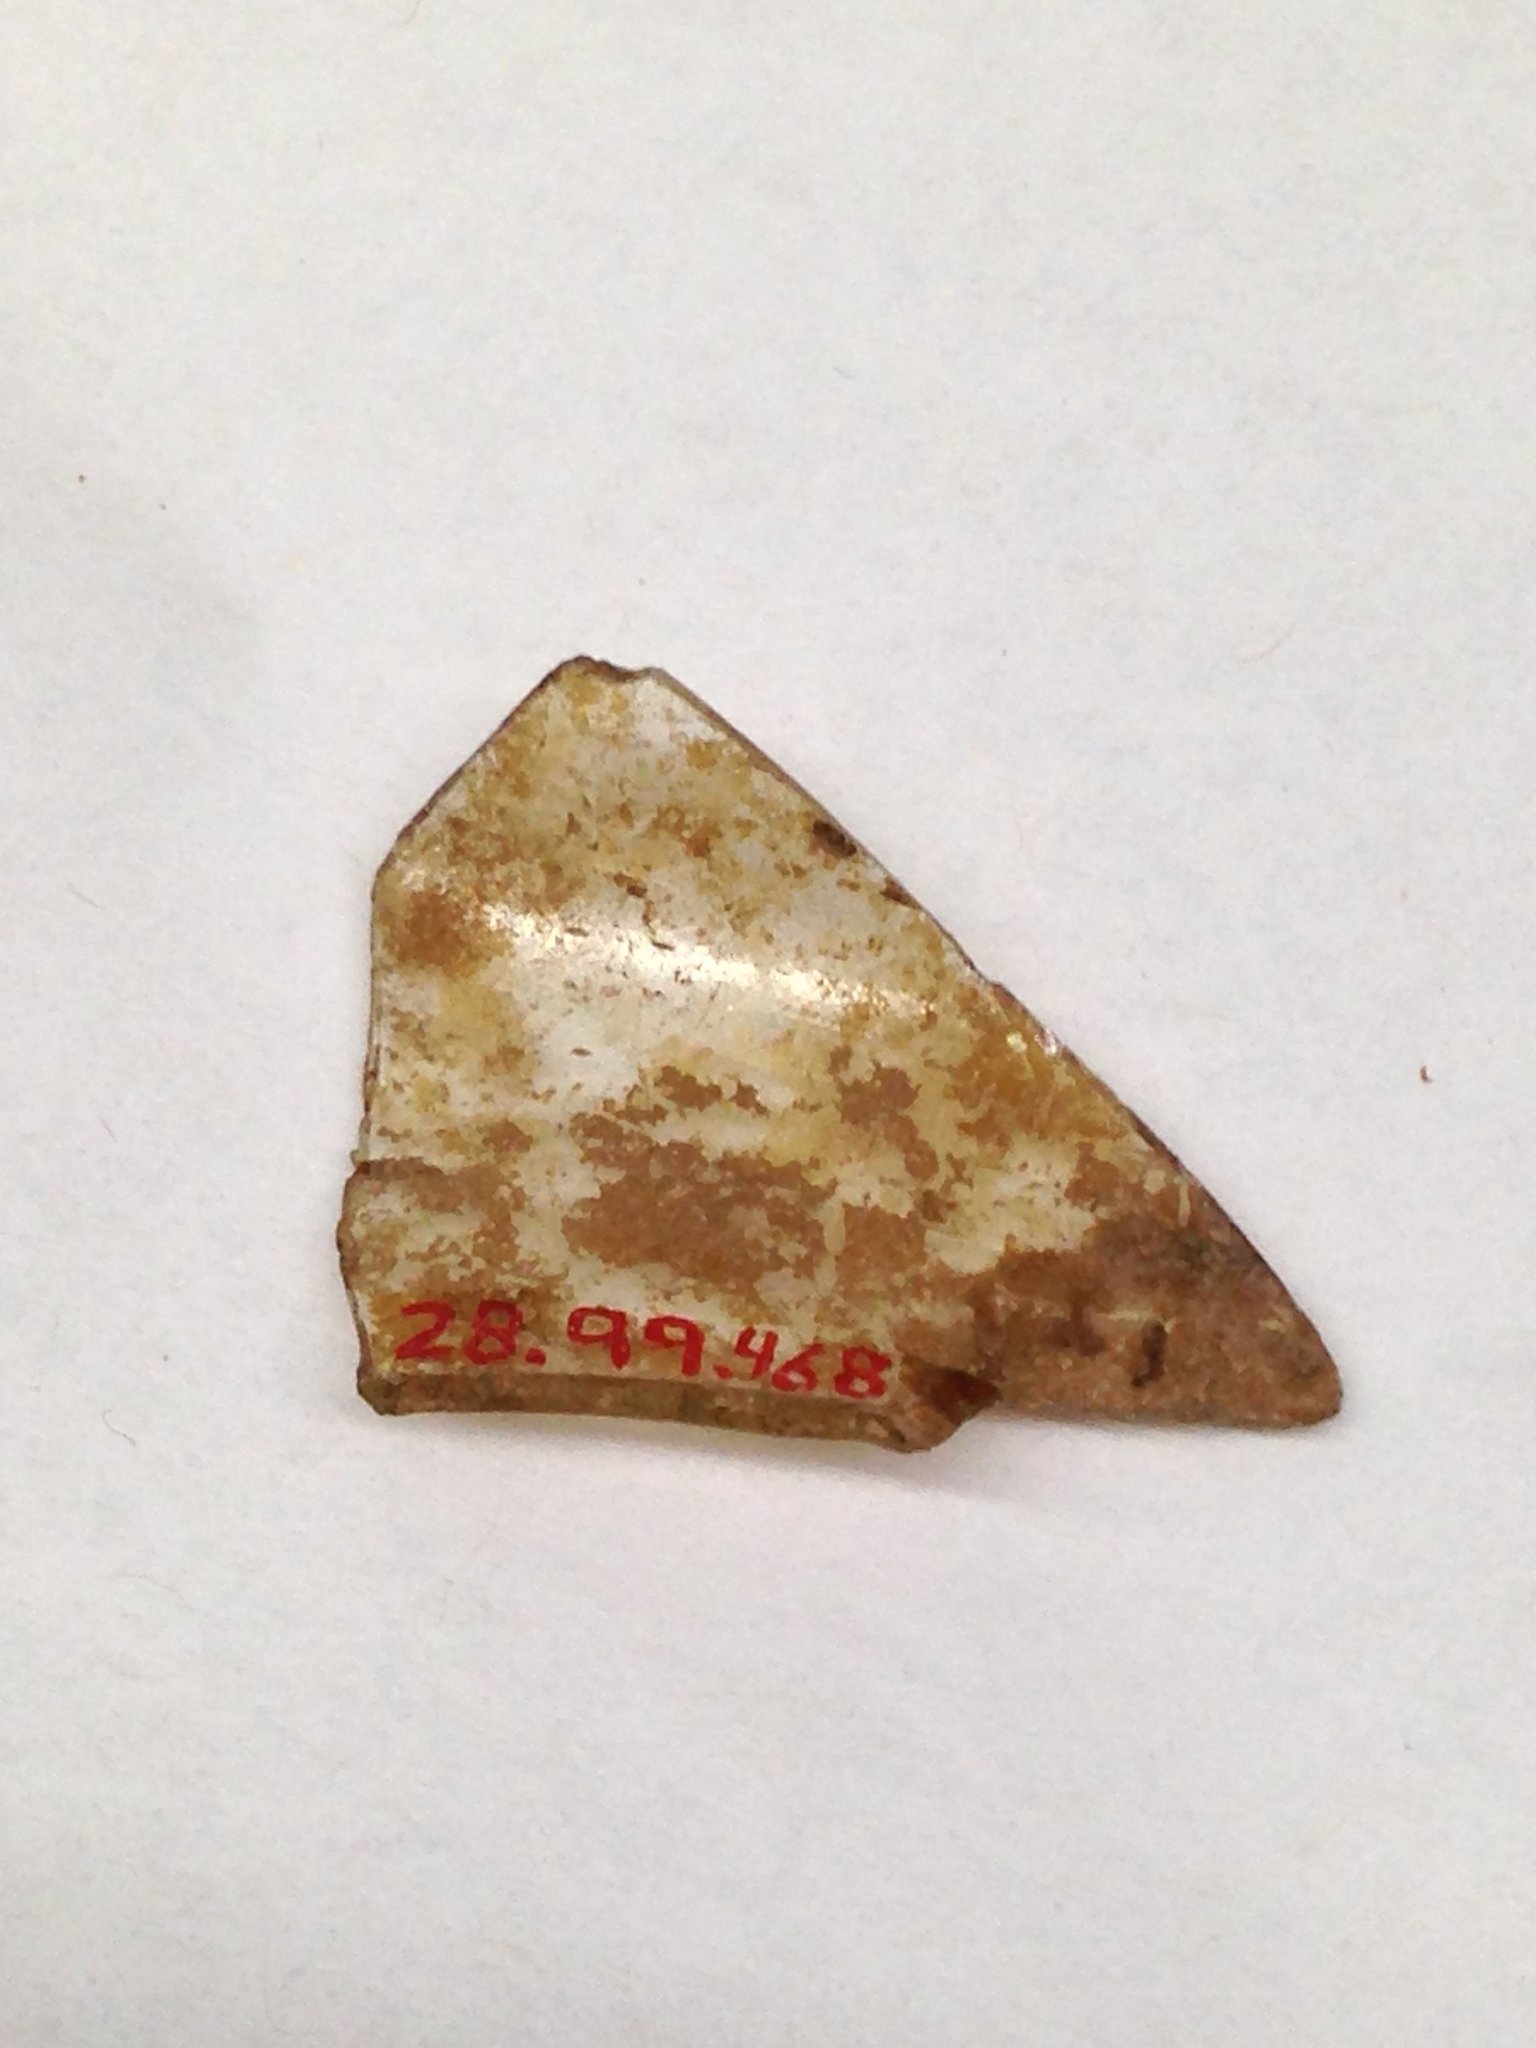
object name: fragment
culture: european or middle eastern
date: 1150-1250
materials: ceramic, glass